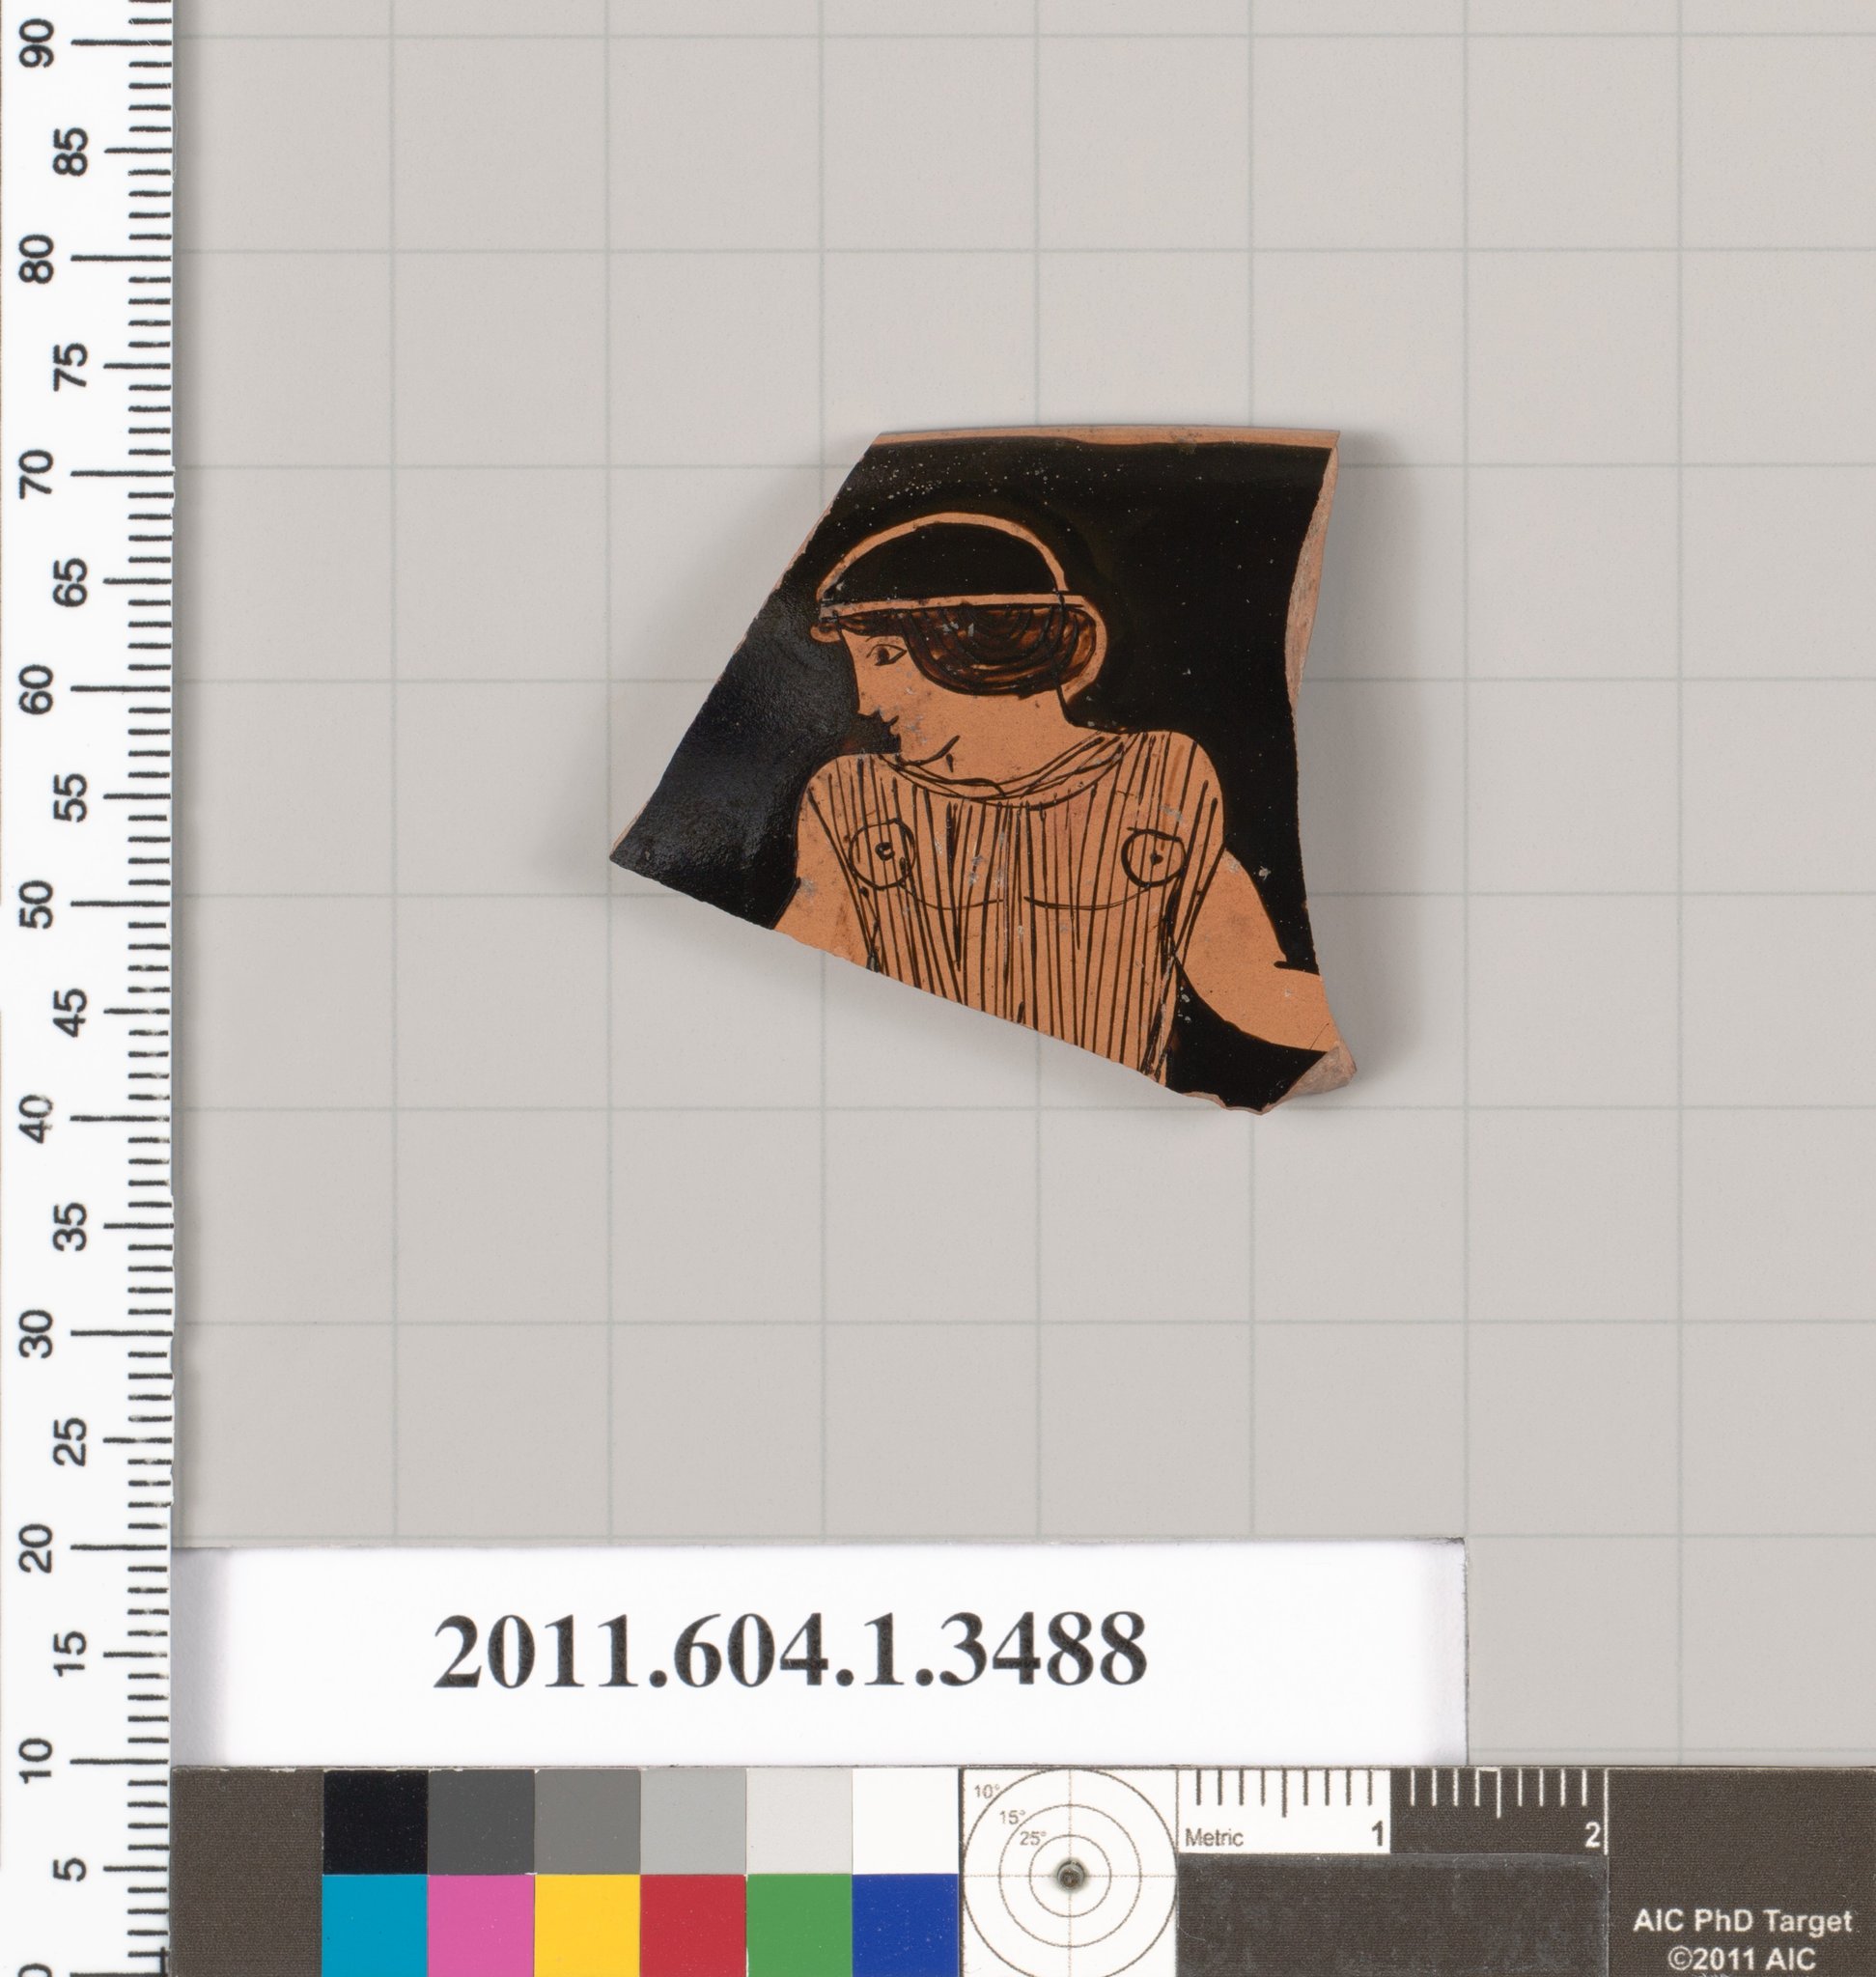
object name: kylix fragment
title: Terracotta fragment of a kylix (drinking cup)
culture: greek, attic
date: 500-476 BCE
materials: terracotta